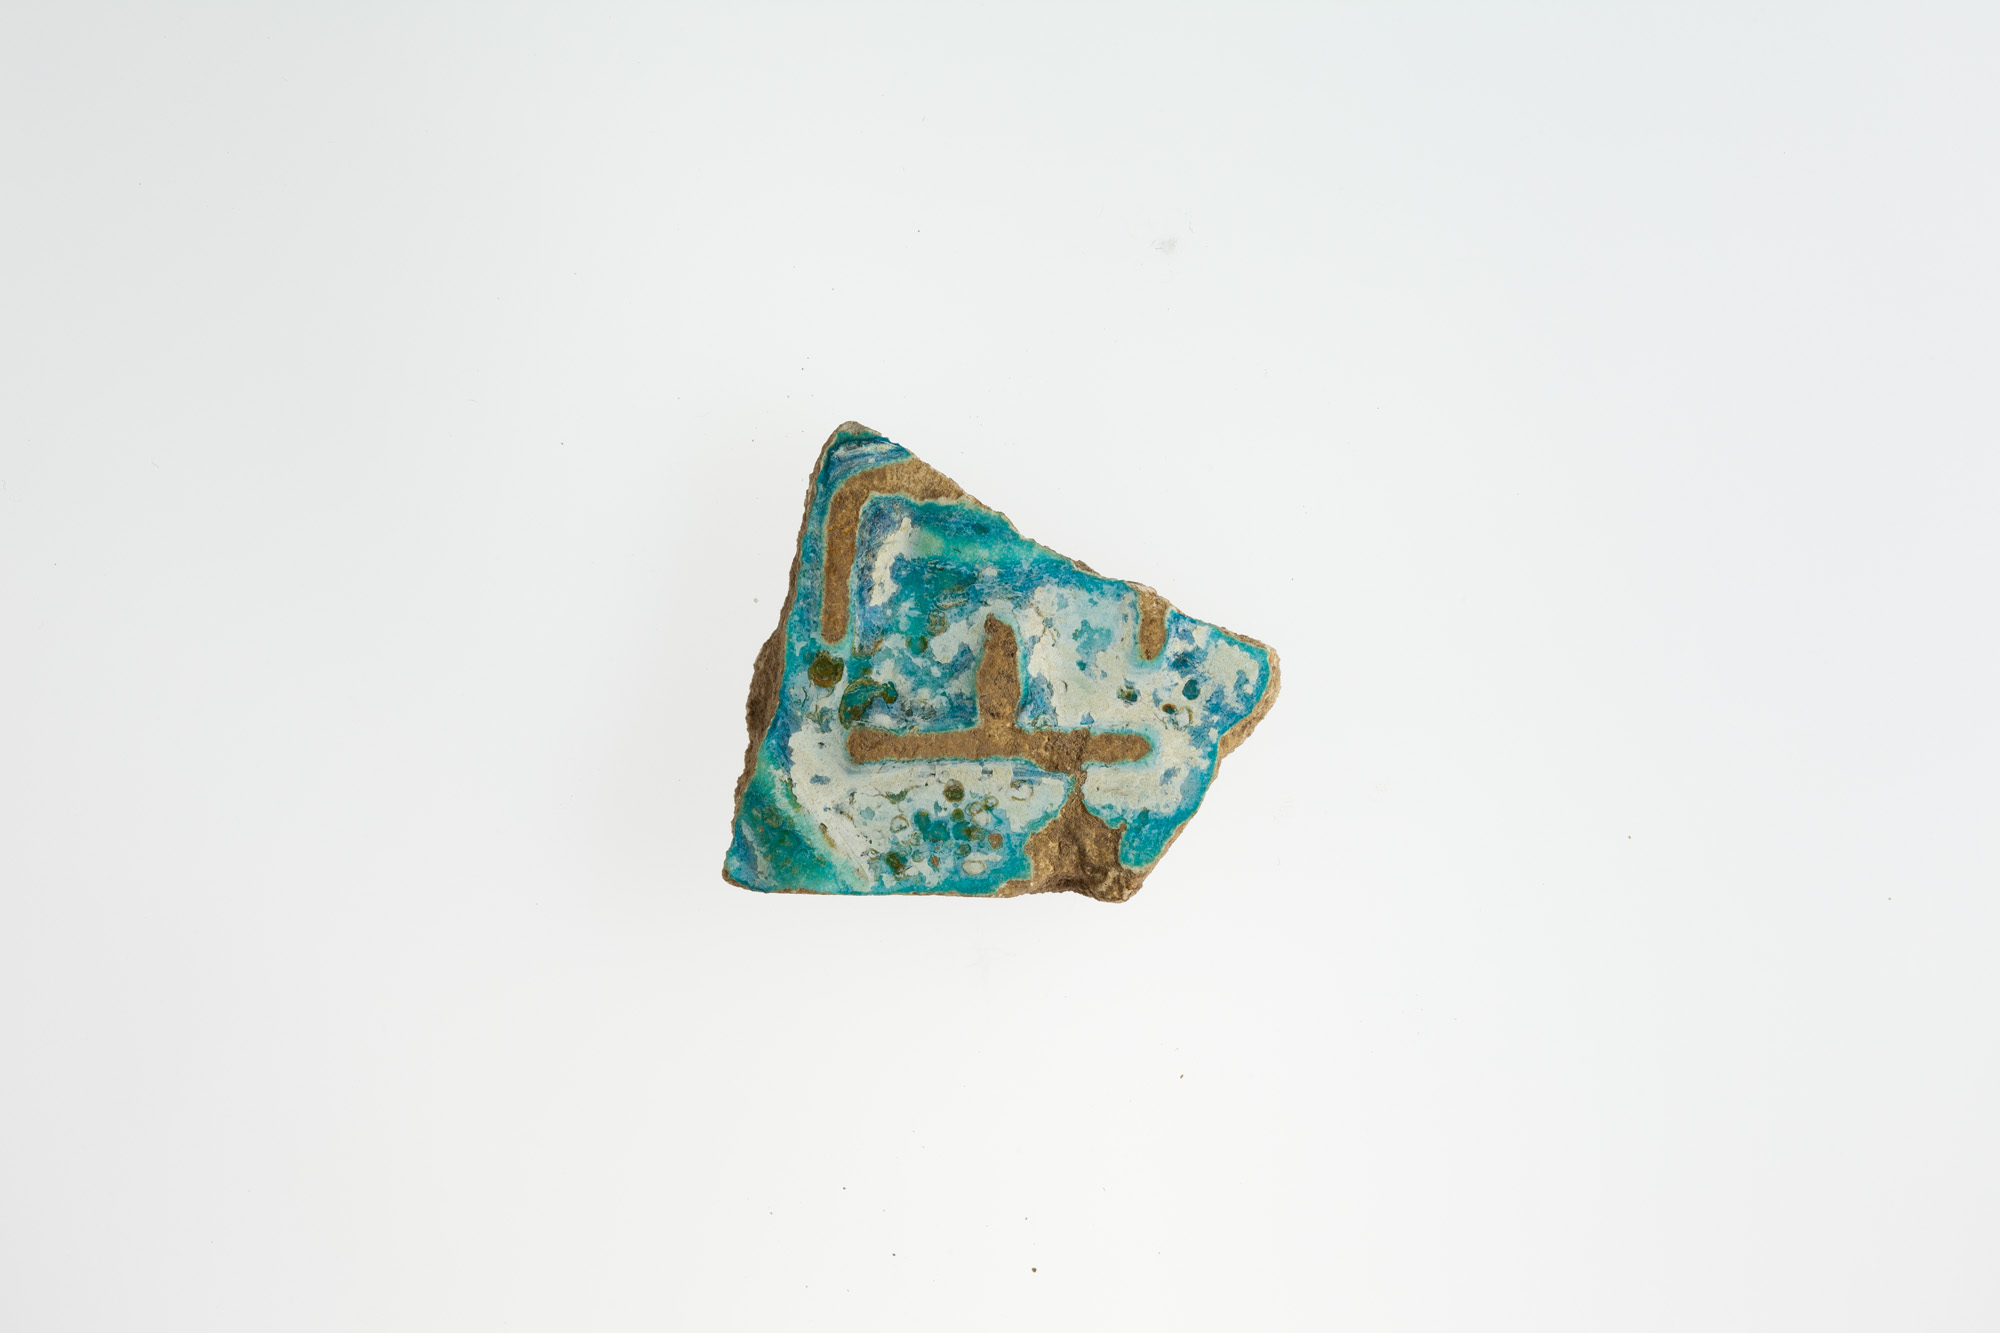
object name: tile fragment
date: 1981-1640 BCE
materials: faience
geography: egypt